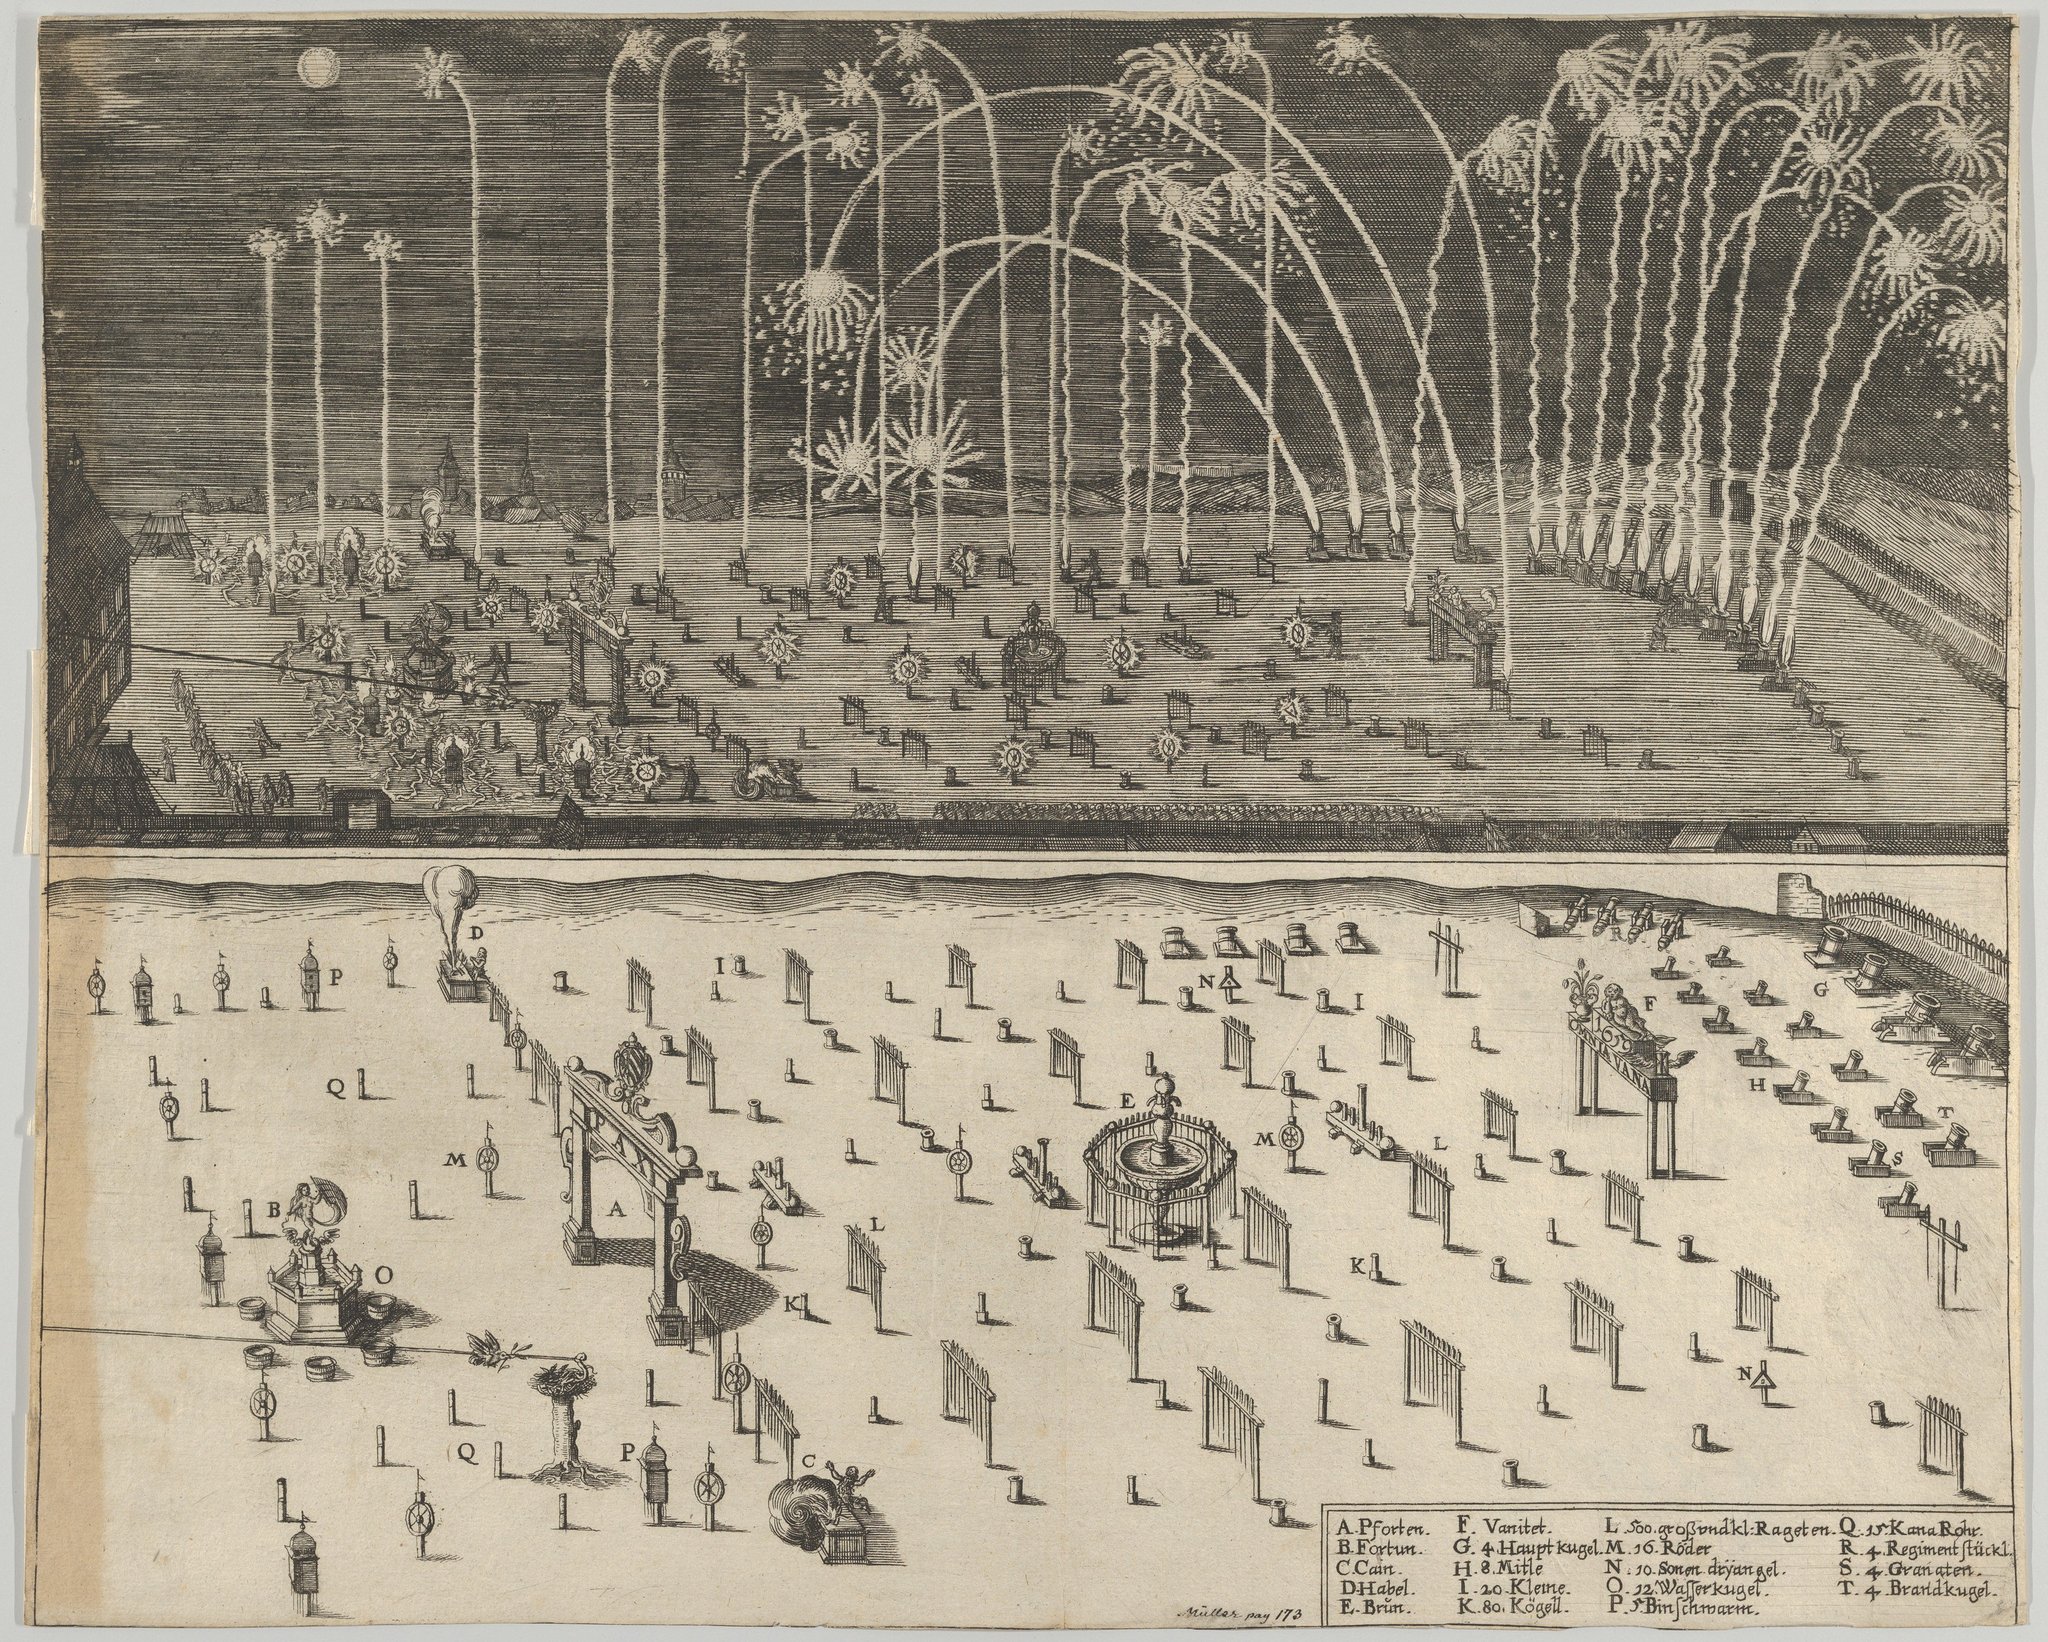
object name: print, fete, ornament architecture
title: Fireworks display, Nuremberg, 1659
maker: Anonymous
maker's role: artist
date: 1659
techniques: etching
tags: fireworks,night